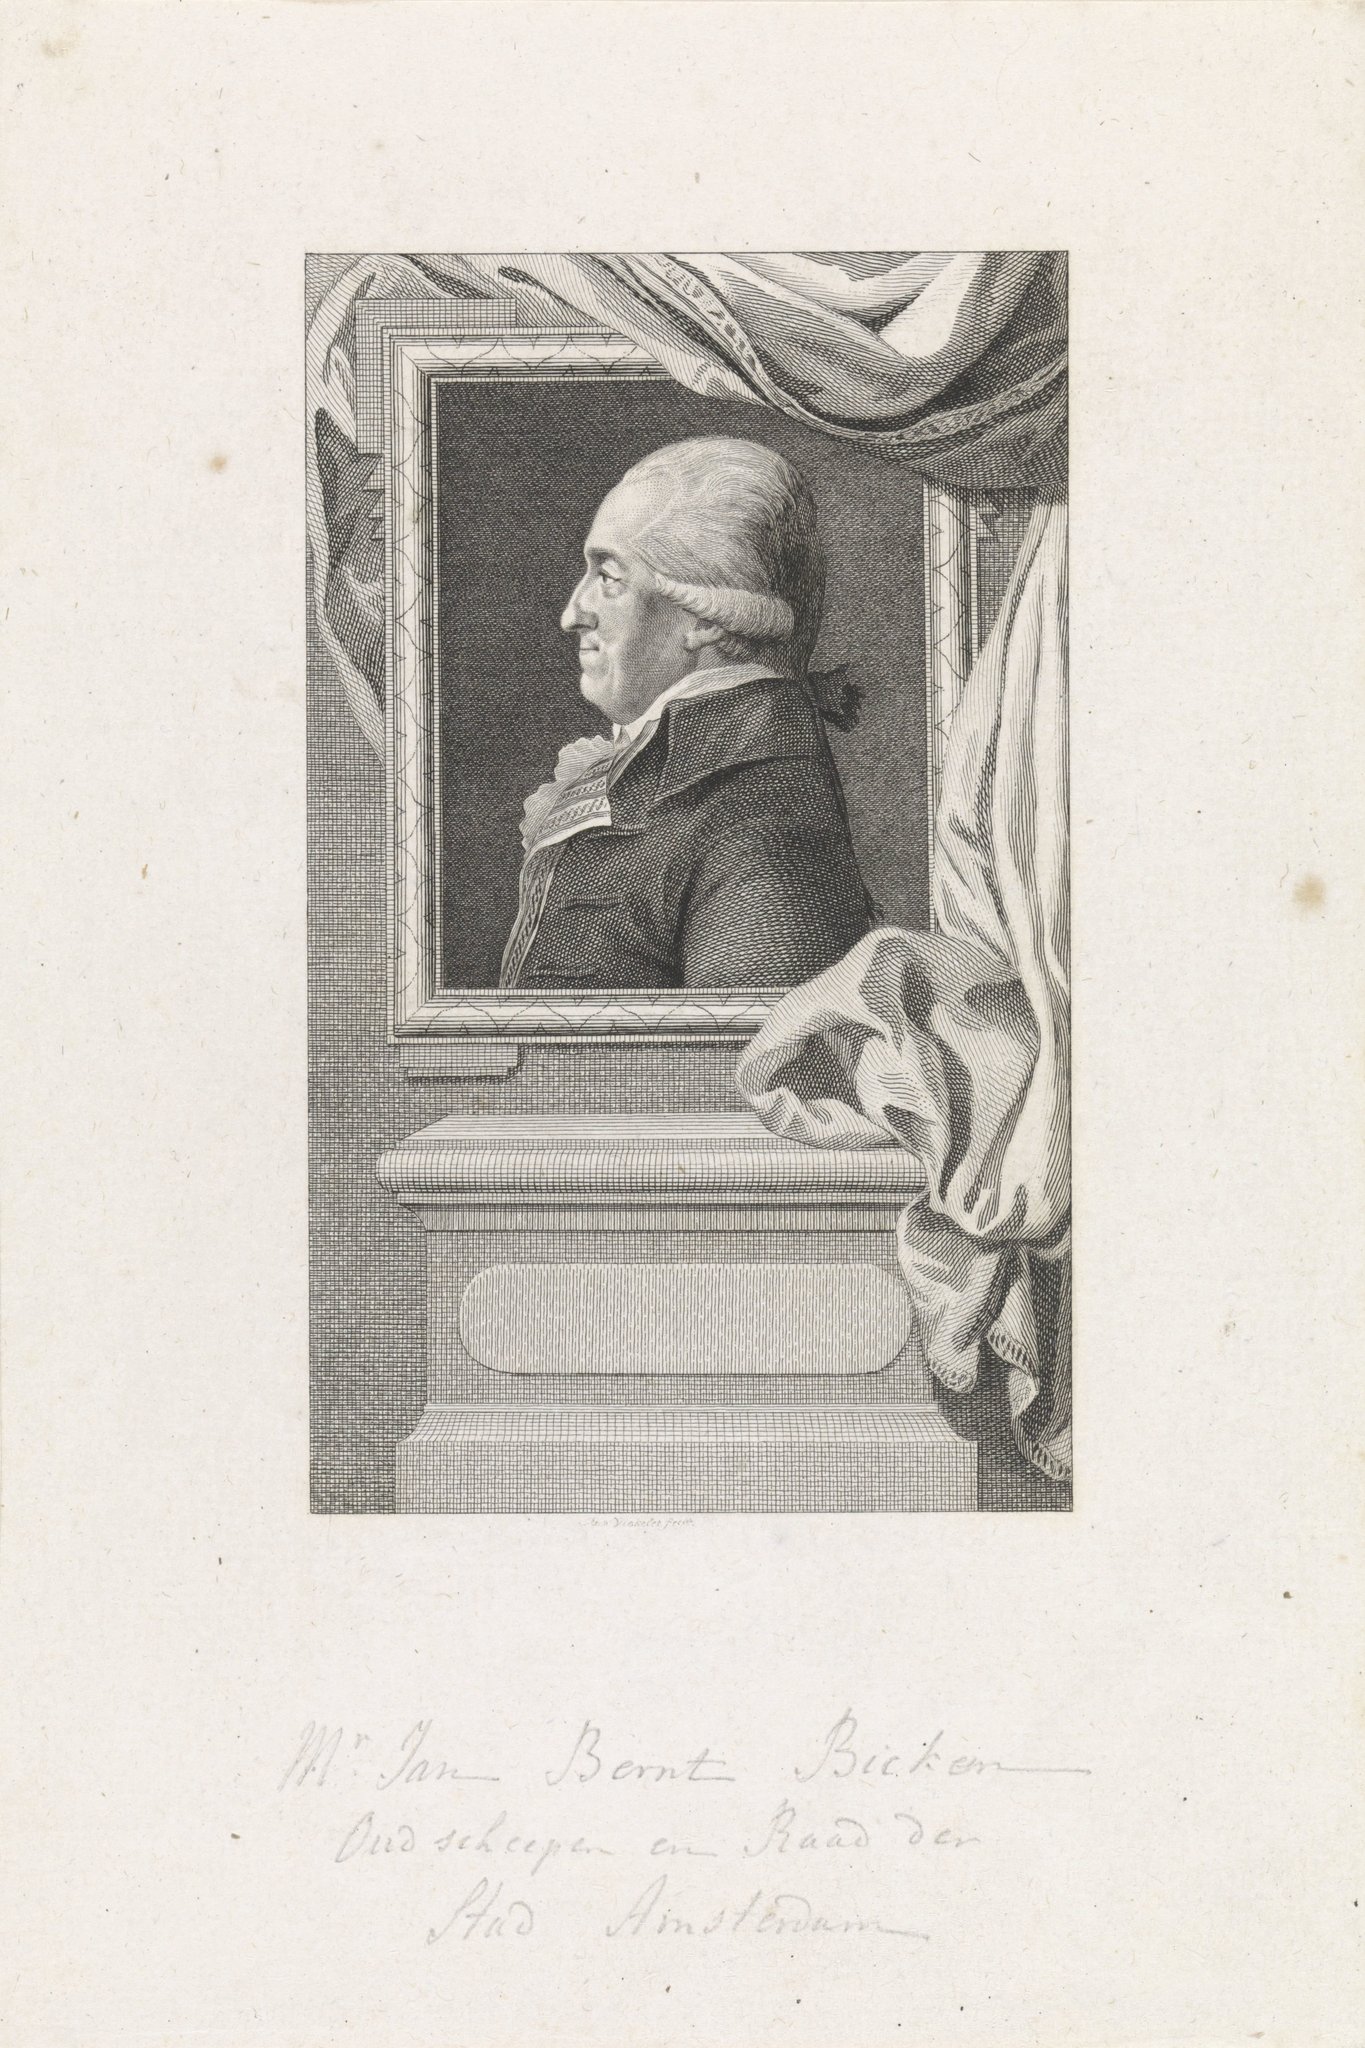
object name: print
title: Portret van Jan Bernd Bicker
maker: reinier vinkeles (i)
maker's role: draughtsman, print maker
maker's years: 1741-1816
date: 1786-1809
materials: paper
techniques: engraving, etching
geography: amsterdam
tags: amsterdam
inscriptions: collector's mark: Lugt 240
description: Latere staat prent gebruikt als boekillustratie in: Wagenaar, Jan. Vaderlandsche historie, (...) ten vervolge van Wagenaars Vaderlandsche historie. Dl. 1-43. Amsterdam: Johannes Allart, 1786-1809.